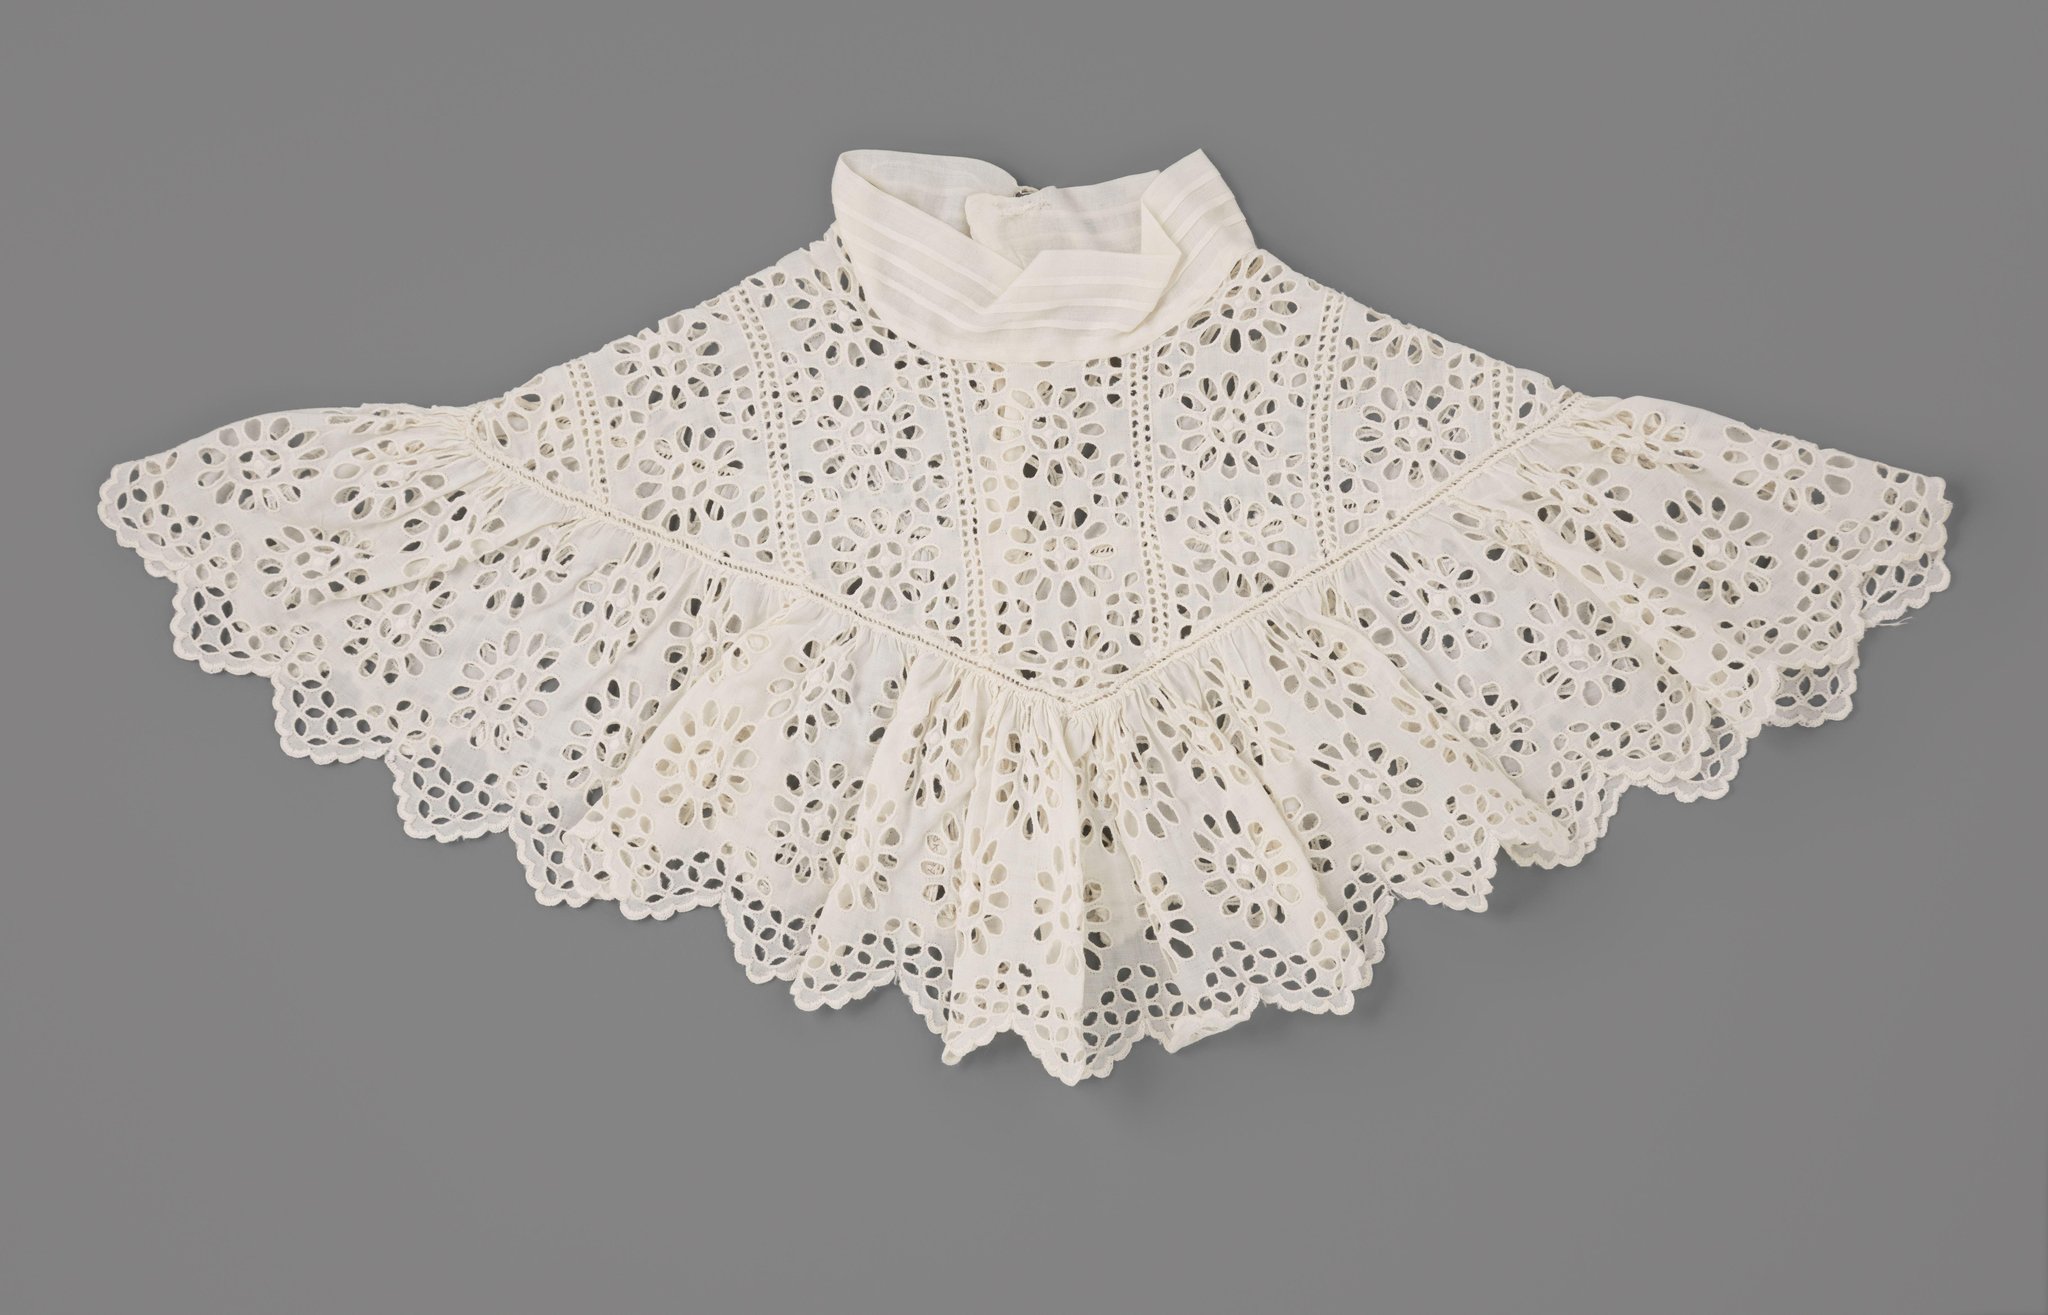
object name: collar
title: Kraag van batist, versierd met Engels borduurwerk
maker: Anonymous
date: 1850-1900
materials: textile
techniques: english embroidery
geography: western europe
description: Liggende kraag van batist, aan de voorzijde uitlopend in een punt. De kraag is afgezet met een aangerimpelde strook met gefestonneerde schulprand. Zowel deze rand als de kraag is versierd met Engels borduurwerk. De kraag heeft een opstaande boord die aan de achterzijde met een drukknoop sluit. De kraag zelf sluit eveneens aan de achterzijde met drie stoffen knopen op rij.